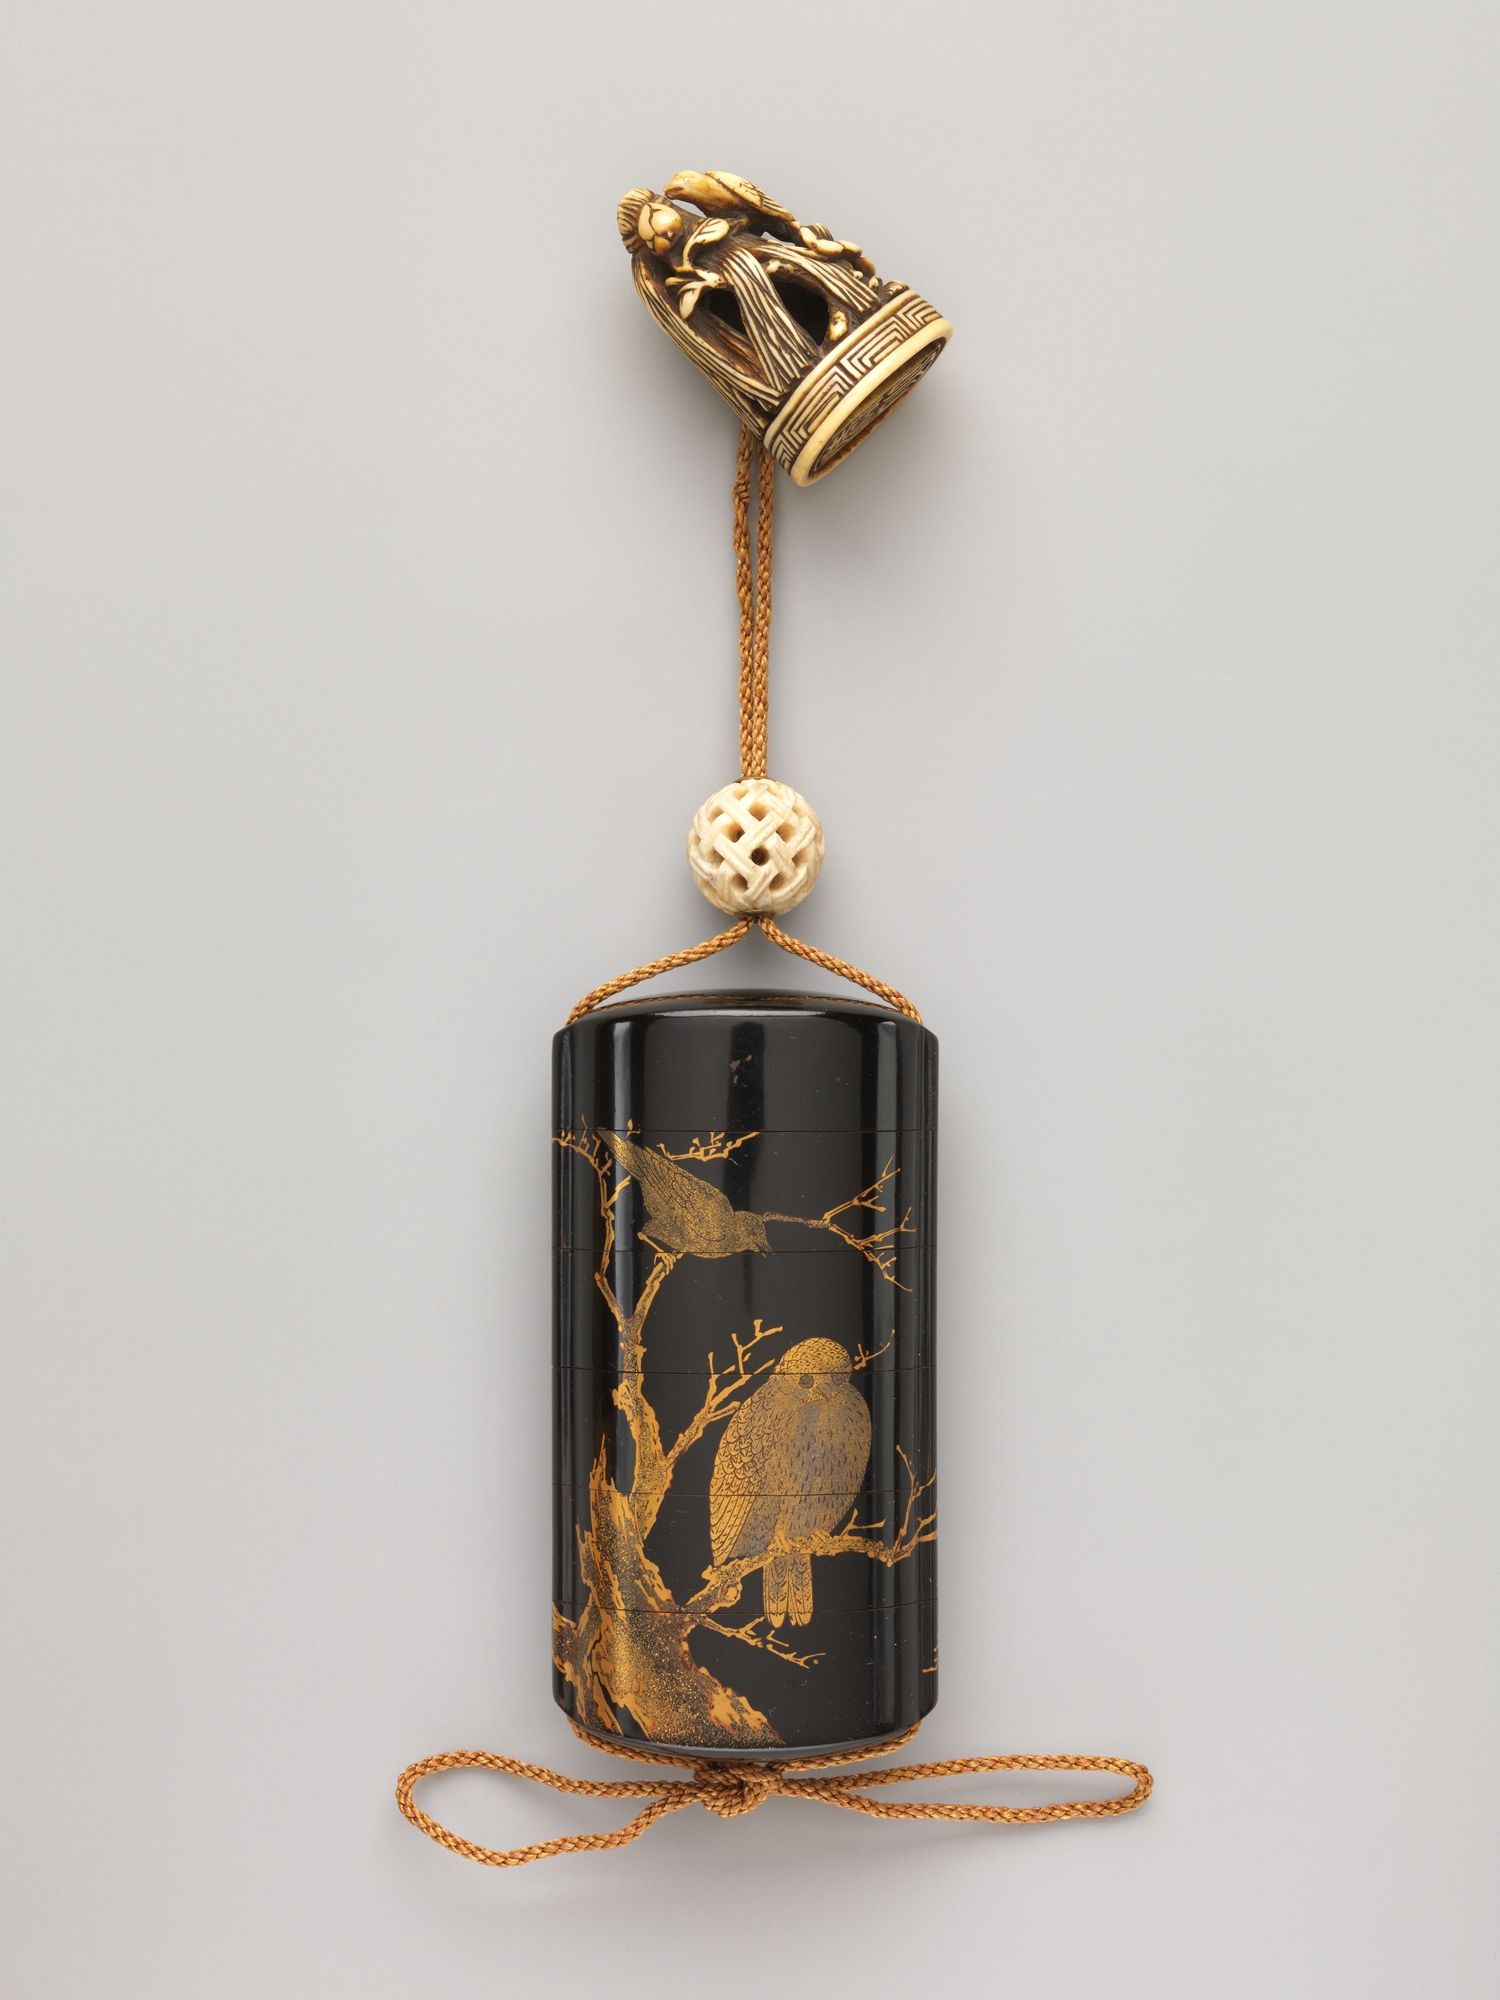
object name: inrō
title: Inrō with Owl and Crows in Tree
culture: japanese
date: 1801-1900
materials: bone, gold, ivory, lacquer, silver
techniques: maki, weave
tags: birds,owls,trees